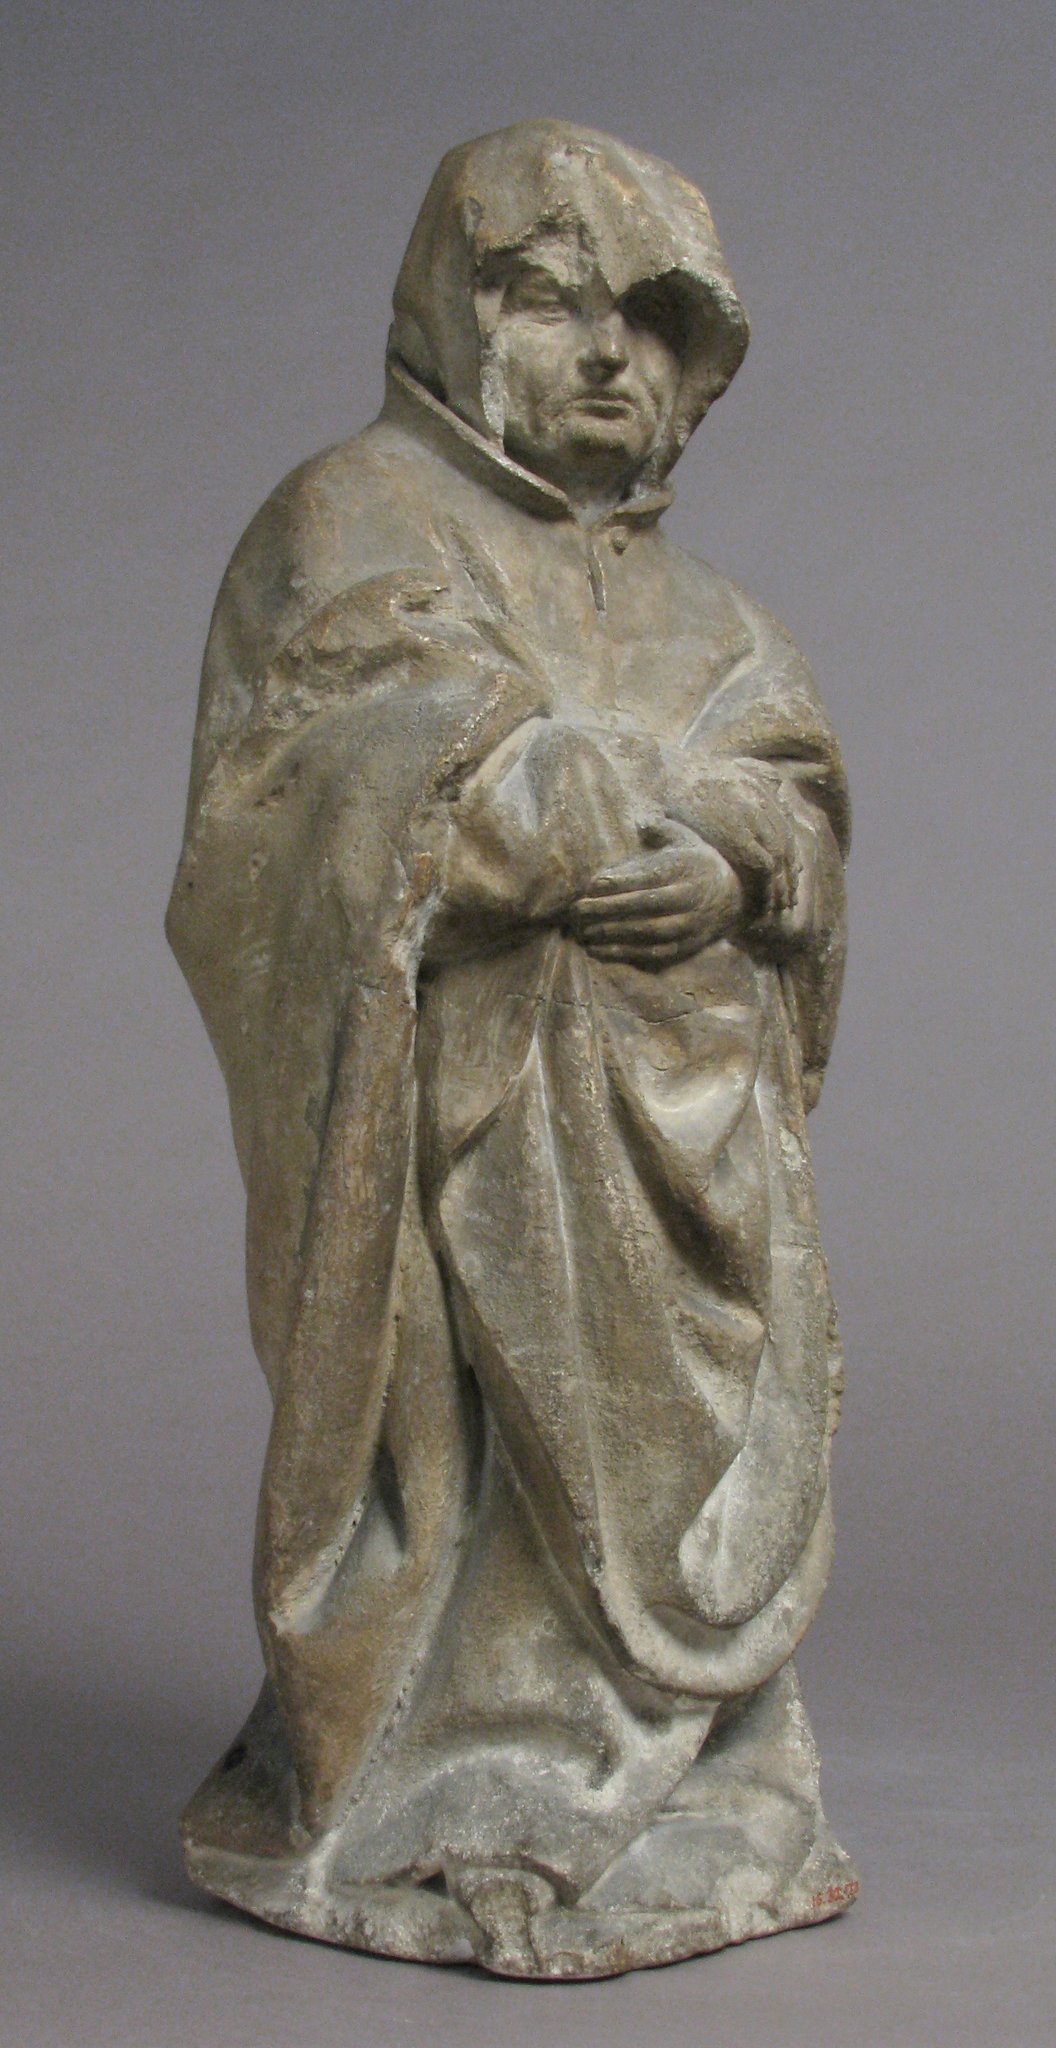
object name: statuette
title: Mourner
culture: french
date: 1434-1466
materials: limestone